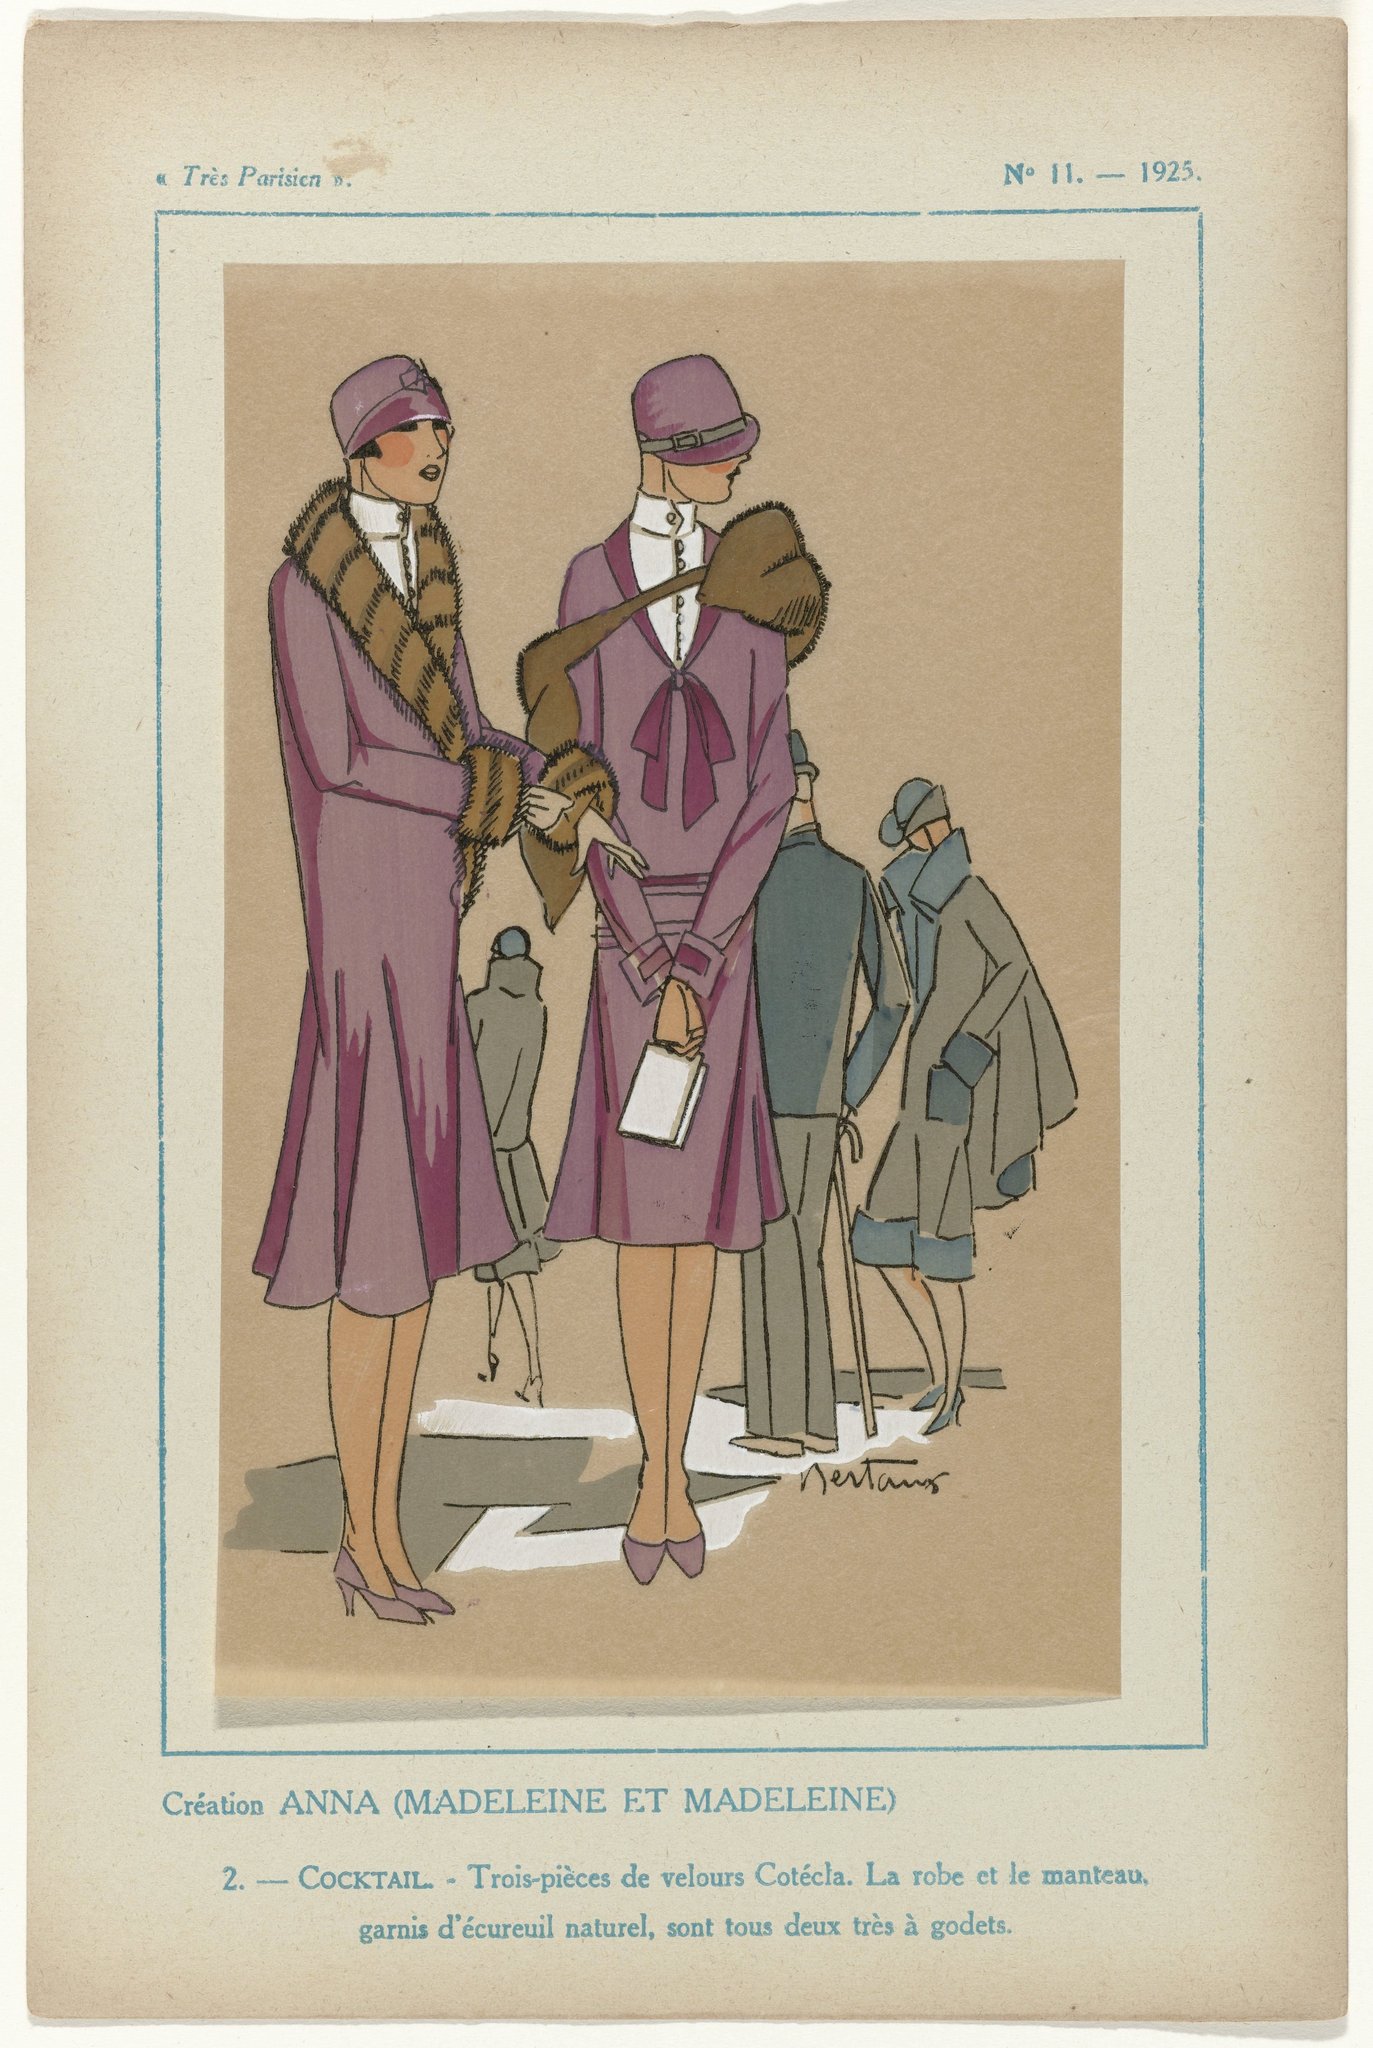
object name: fashion print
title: Très Parisien, 1925, No. 11, Pl. 2: Création ANNA (MADELEINE ET MADELEINE) - COCKTAIL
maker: g-p. joumard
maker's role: publisher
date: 1925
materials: paper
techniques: hand coloring, letterpress printing, lithography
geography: paris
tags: ensembles of pieces of clothing (three piece suit) (+ women's clothes), fashion plates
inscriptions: caption: ‘2. - Cocktail. - Trois-pièces de velours Cotécla. La robe et le manteau, garnis d'écureuil naturel, sont tous deux très à godets.’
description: Cocktail: driedelig ensemble van fluweel van modehuis Anna. Prent uit het modetijdschrift Très Parisien...La Mode, Le Chic, L'Élégance (1920-1936)